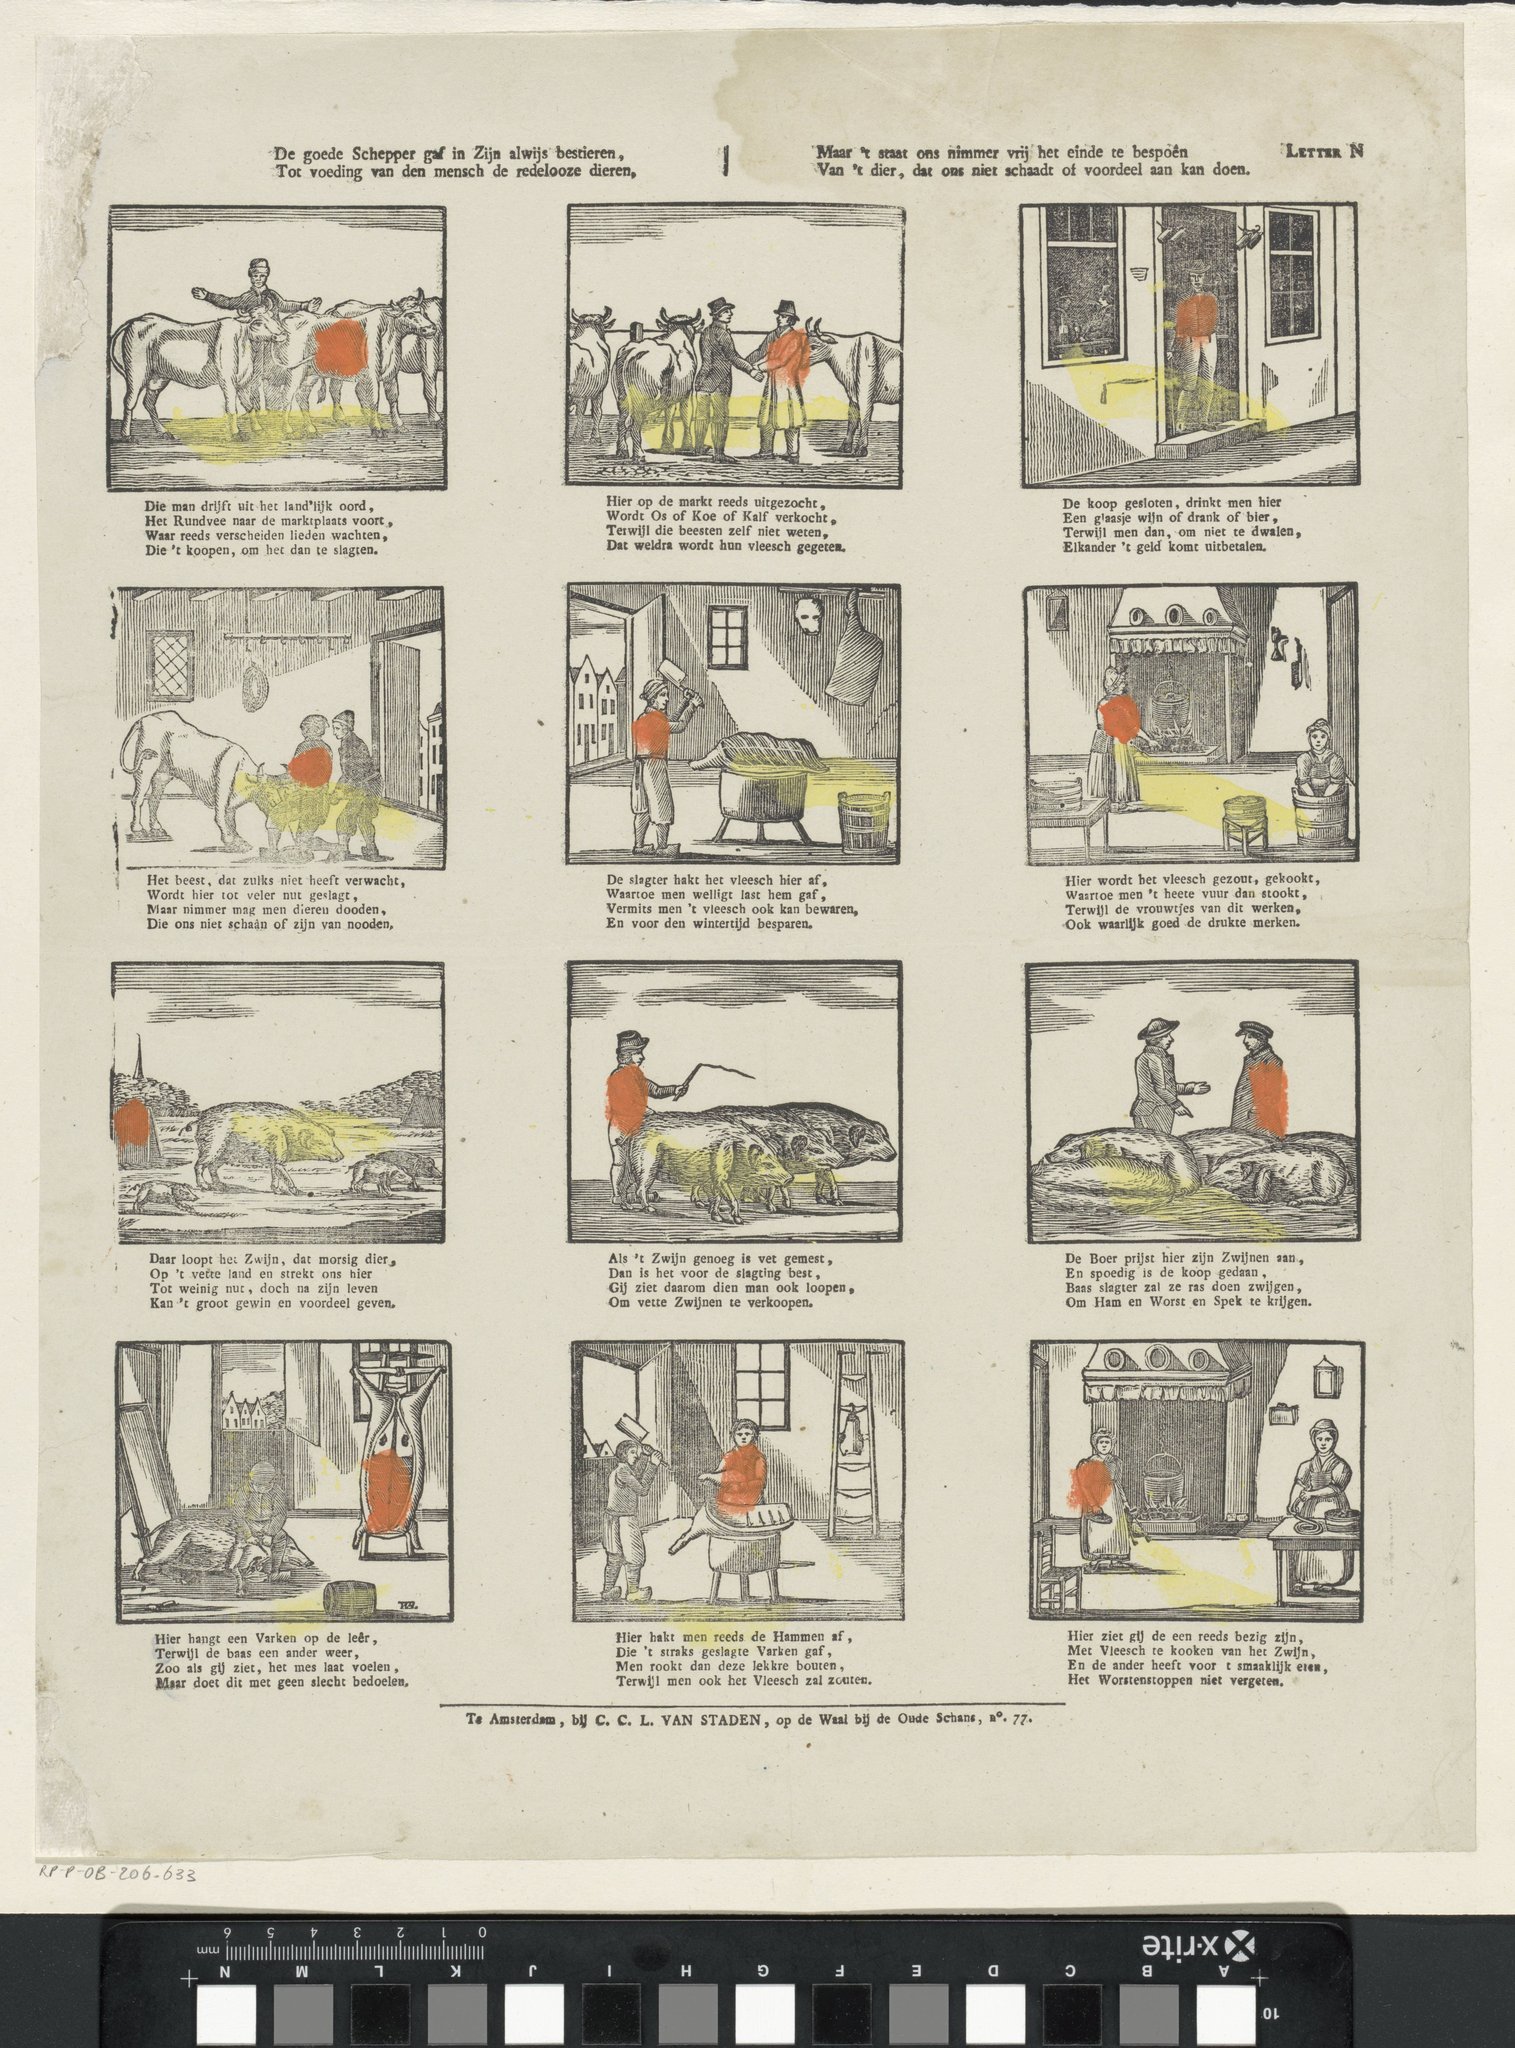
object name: print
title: De goede schepper gaf in zijn alwijs bestieren, / Tot voeding van den mensch de redelooze dieren, / Maar 't staat ons nimmer vrij het einde te bespoên / Van 't dier, dat ons niet schaadt of voordeel aan kan doen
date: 1822-1870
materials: paper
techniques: colour, letterpress printing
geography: netherlands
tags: pig, cow, slaughtered ox or pig, butcher, slaughterman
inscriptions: collector's mark: Lugt 2760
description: Blad met 12 voorstellingen van het fokken, slachten en bereiden van koeien en varkens. Onder elke afbeelding een vierregelig vers. Rechtsboven gemerkt: Letter N.